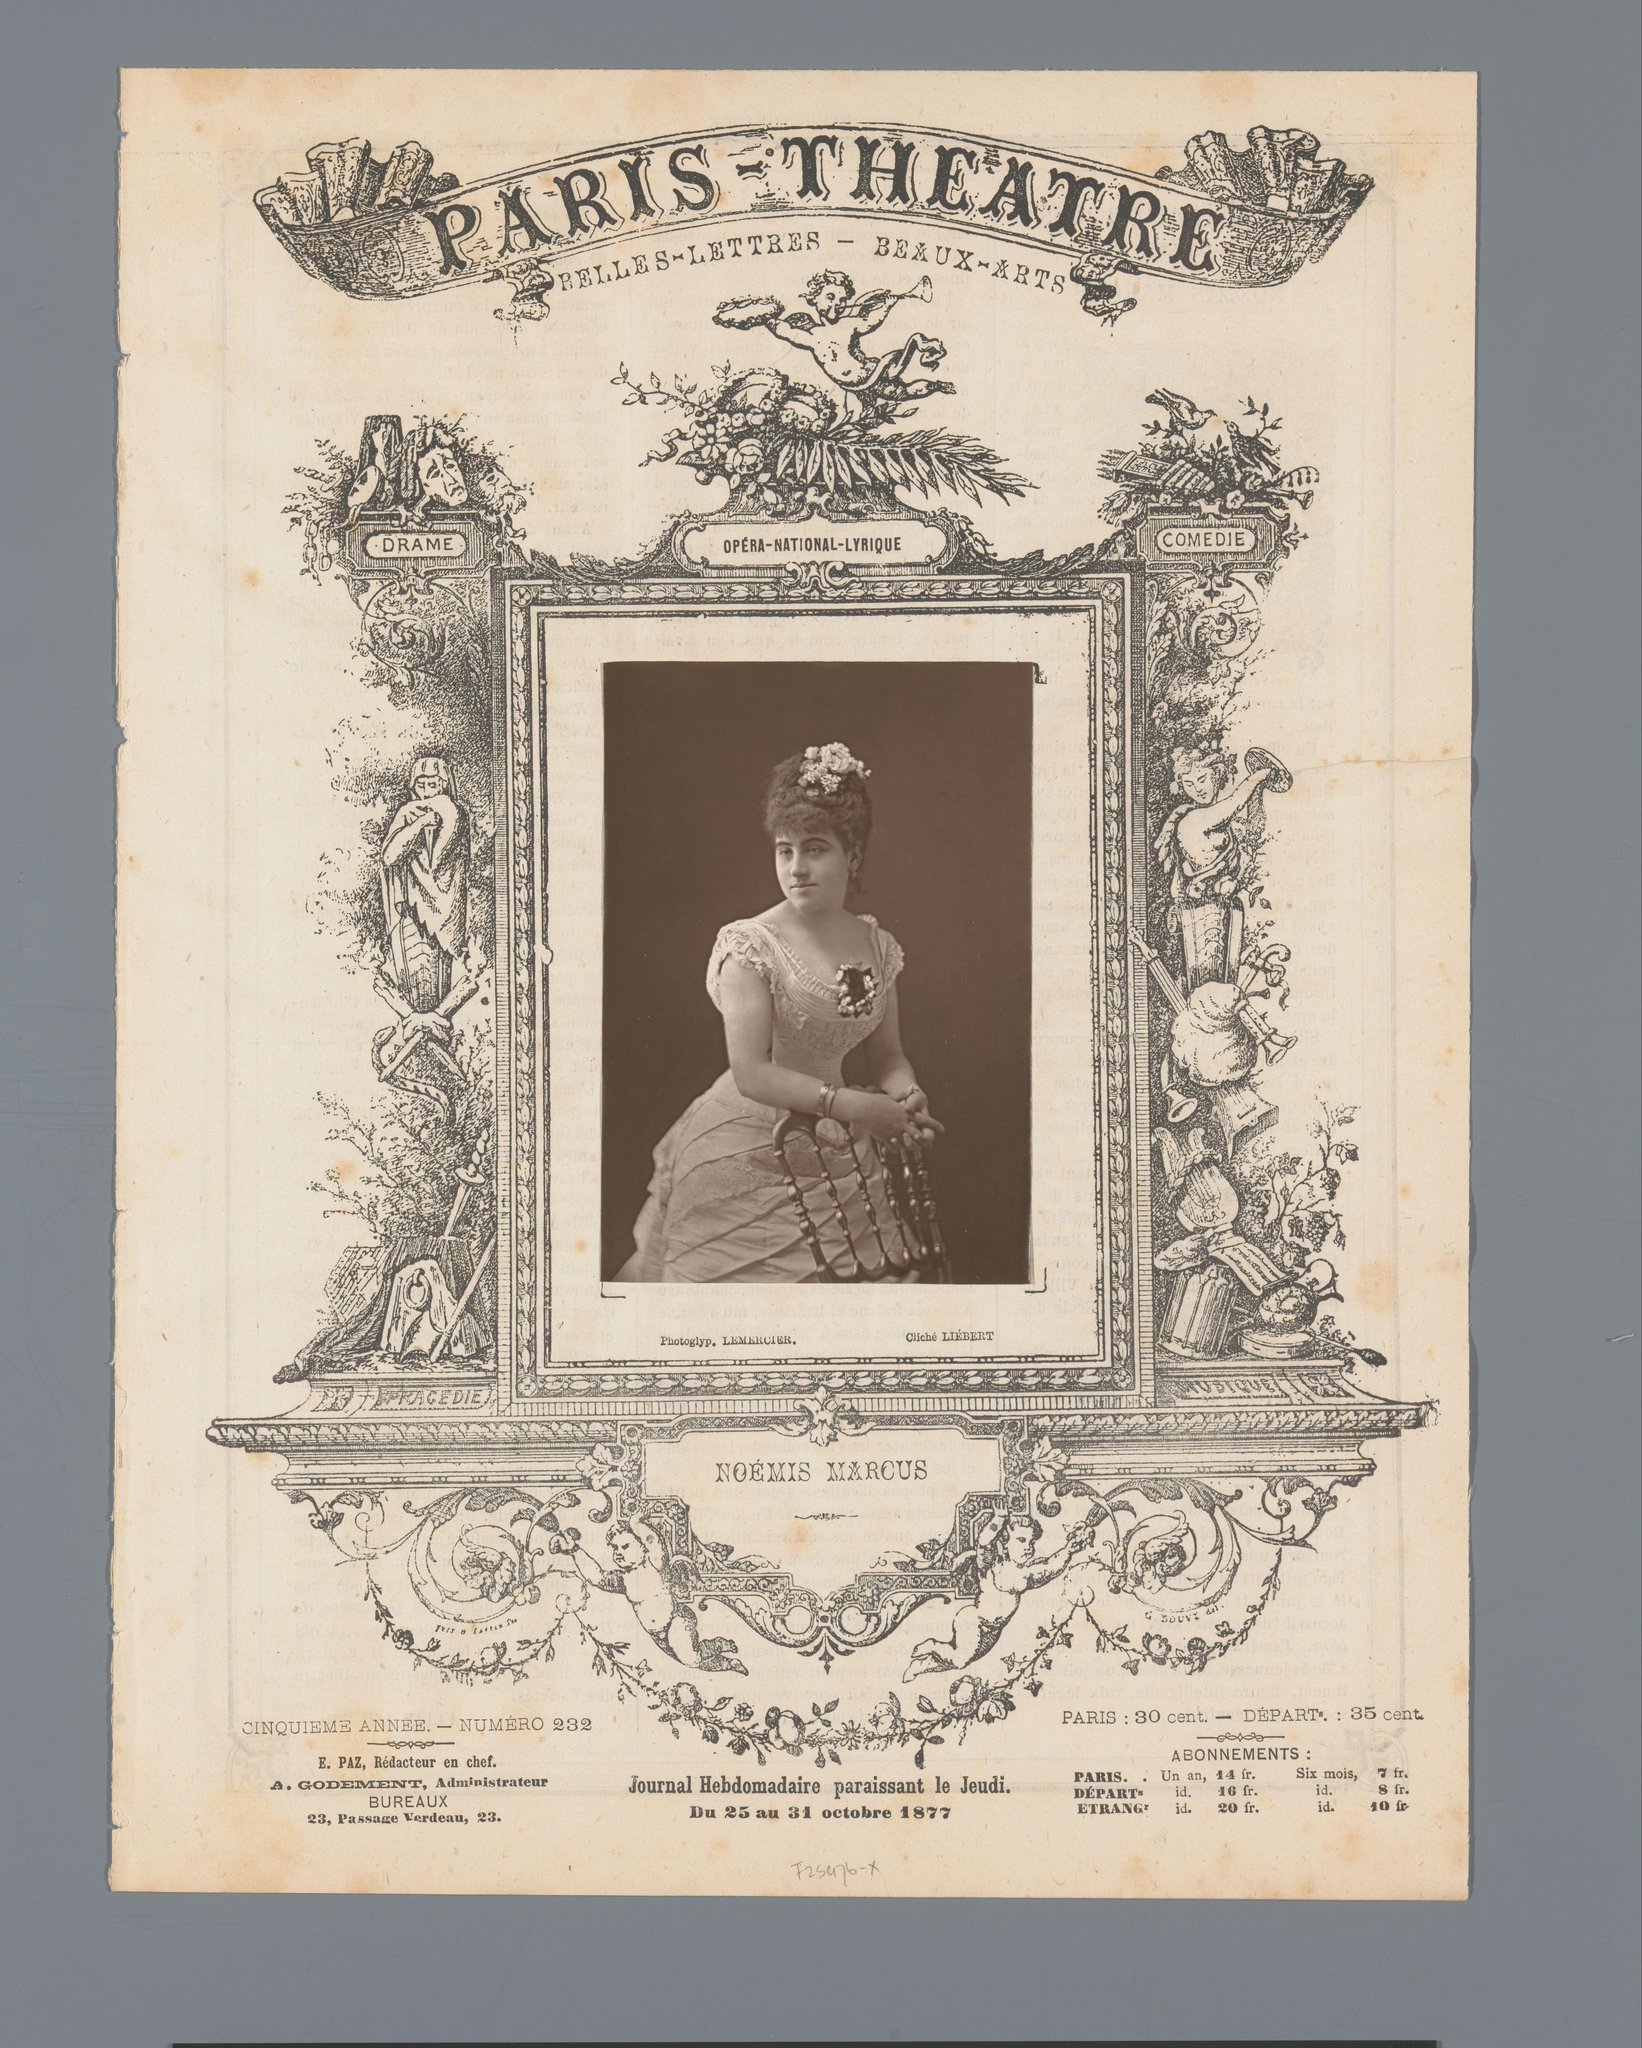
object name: photomechanical print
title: Portret van Noémis Marcus de Beaucourt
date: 1872-1879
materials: paper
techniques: woodburytype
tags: historical persons - bb - woman